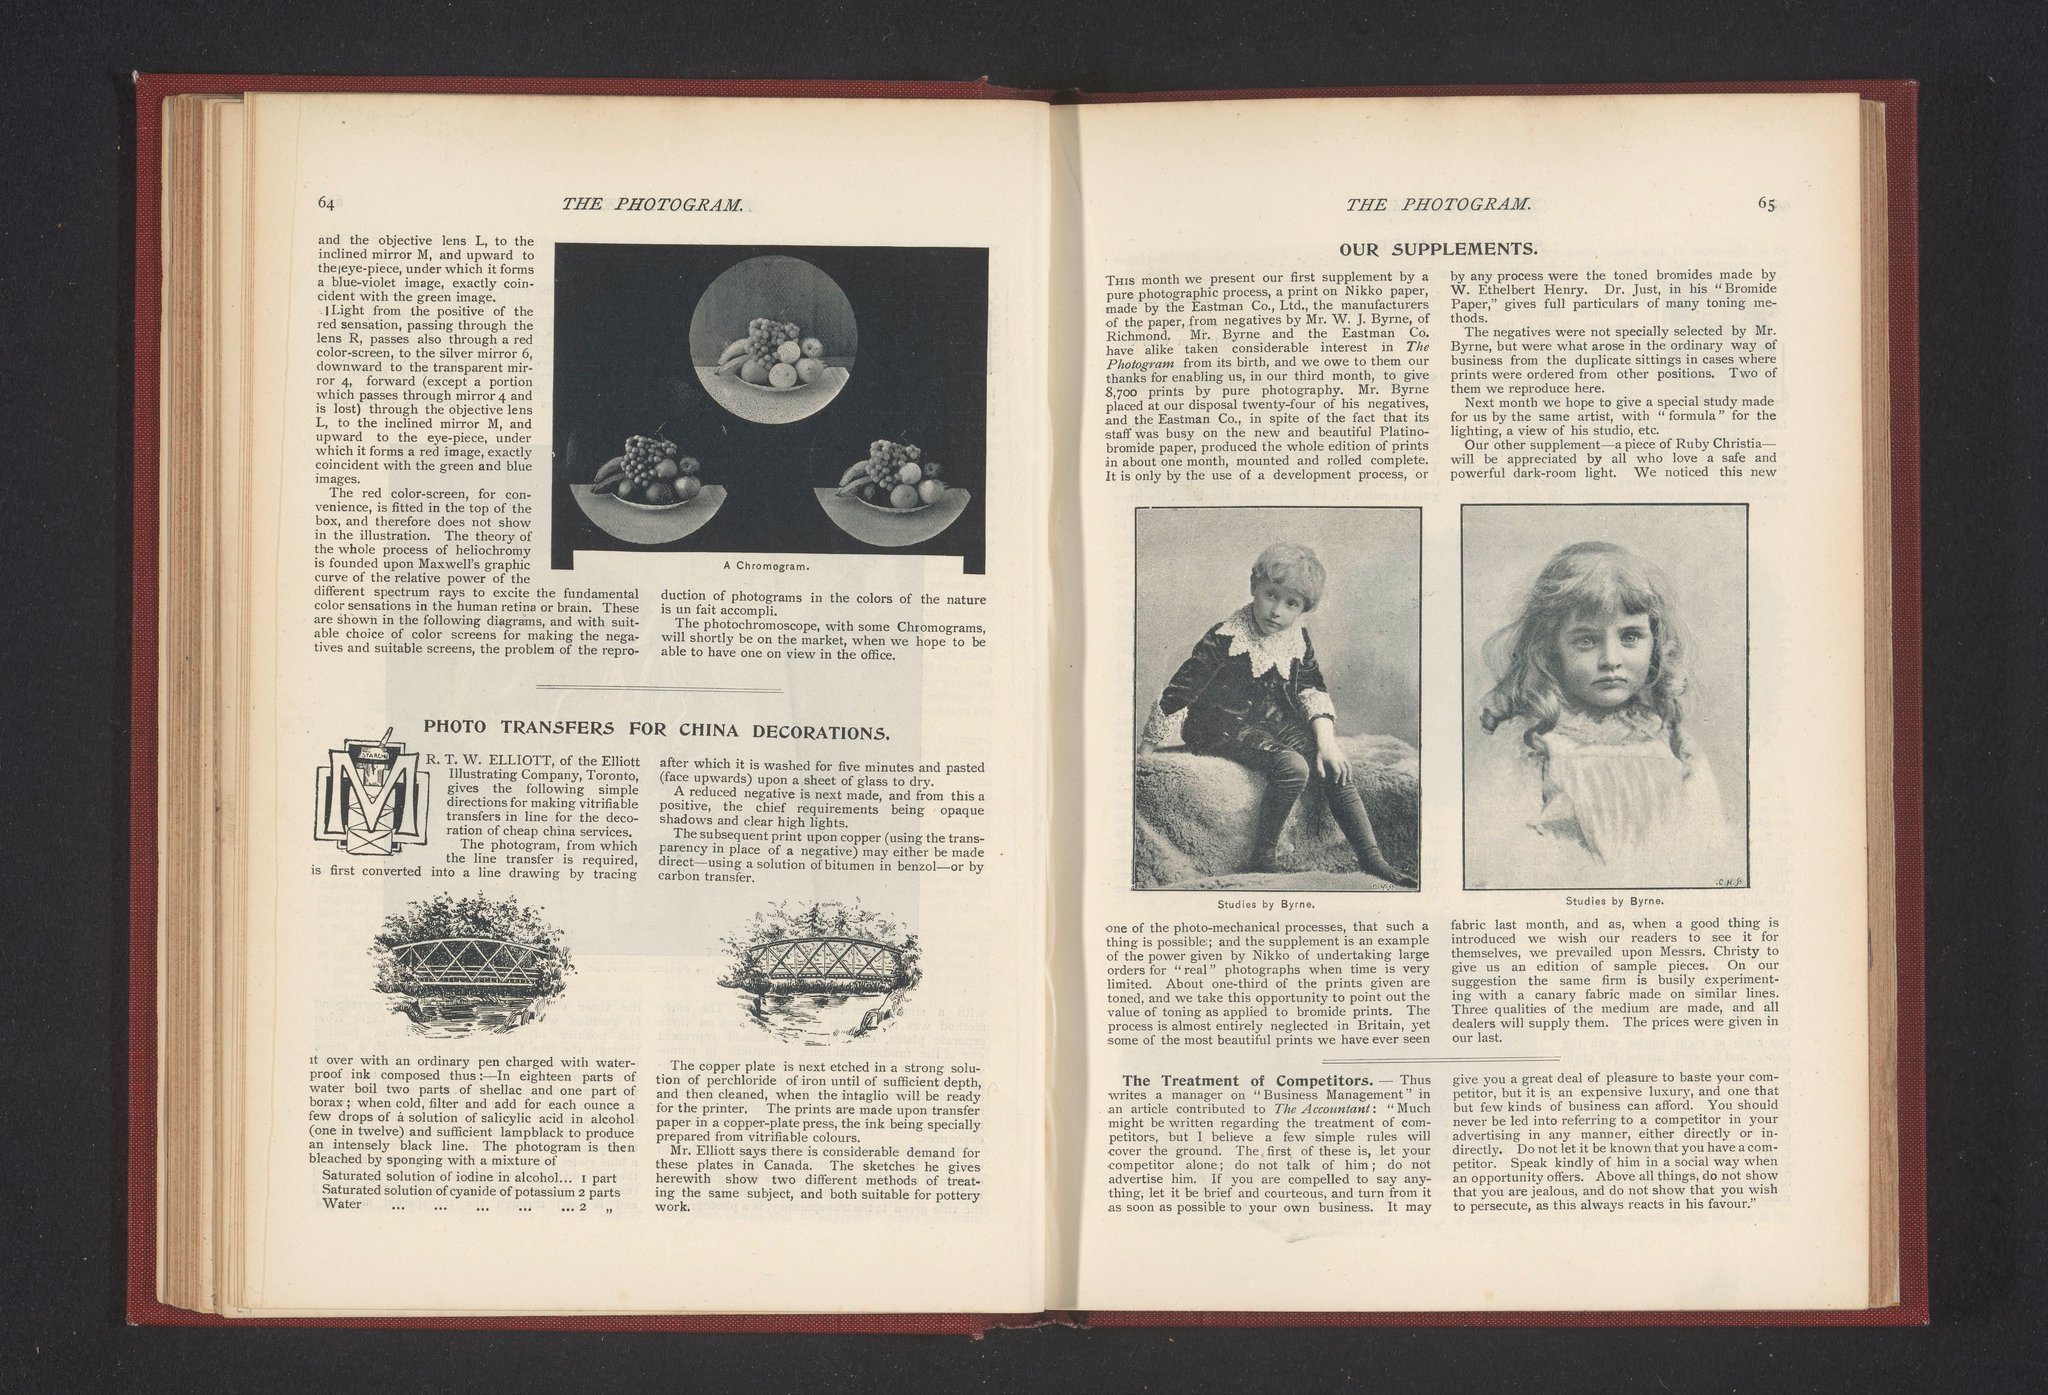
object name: photomechanical print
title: Studies by Byrne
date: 1889-1894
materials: paper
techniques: autotype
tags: boy (child between toddler and youth), historical persons